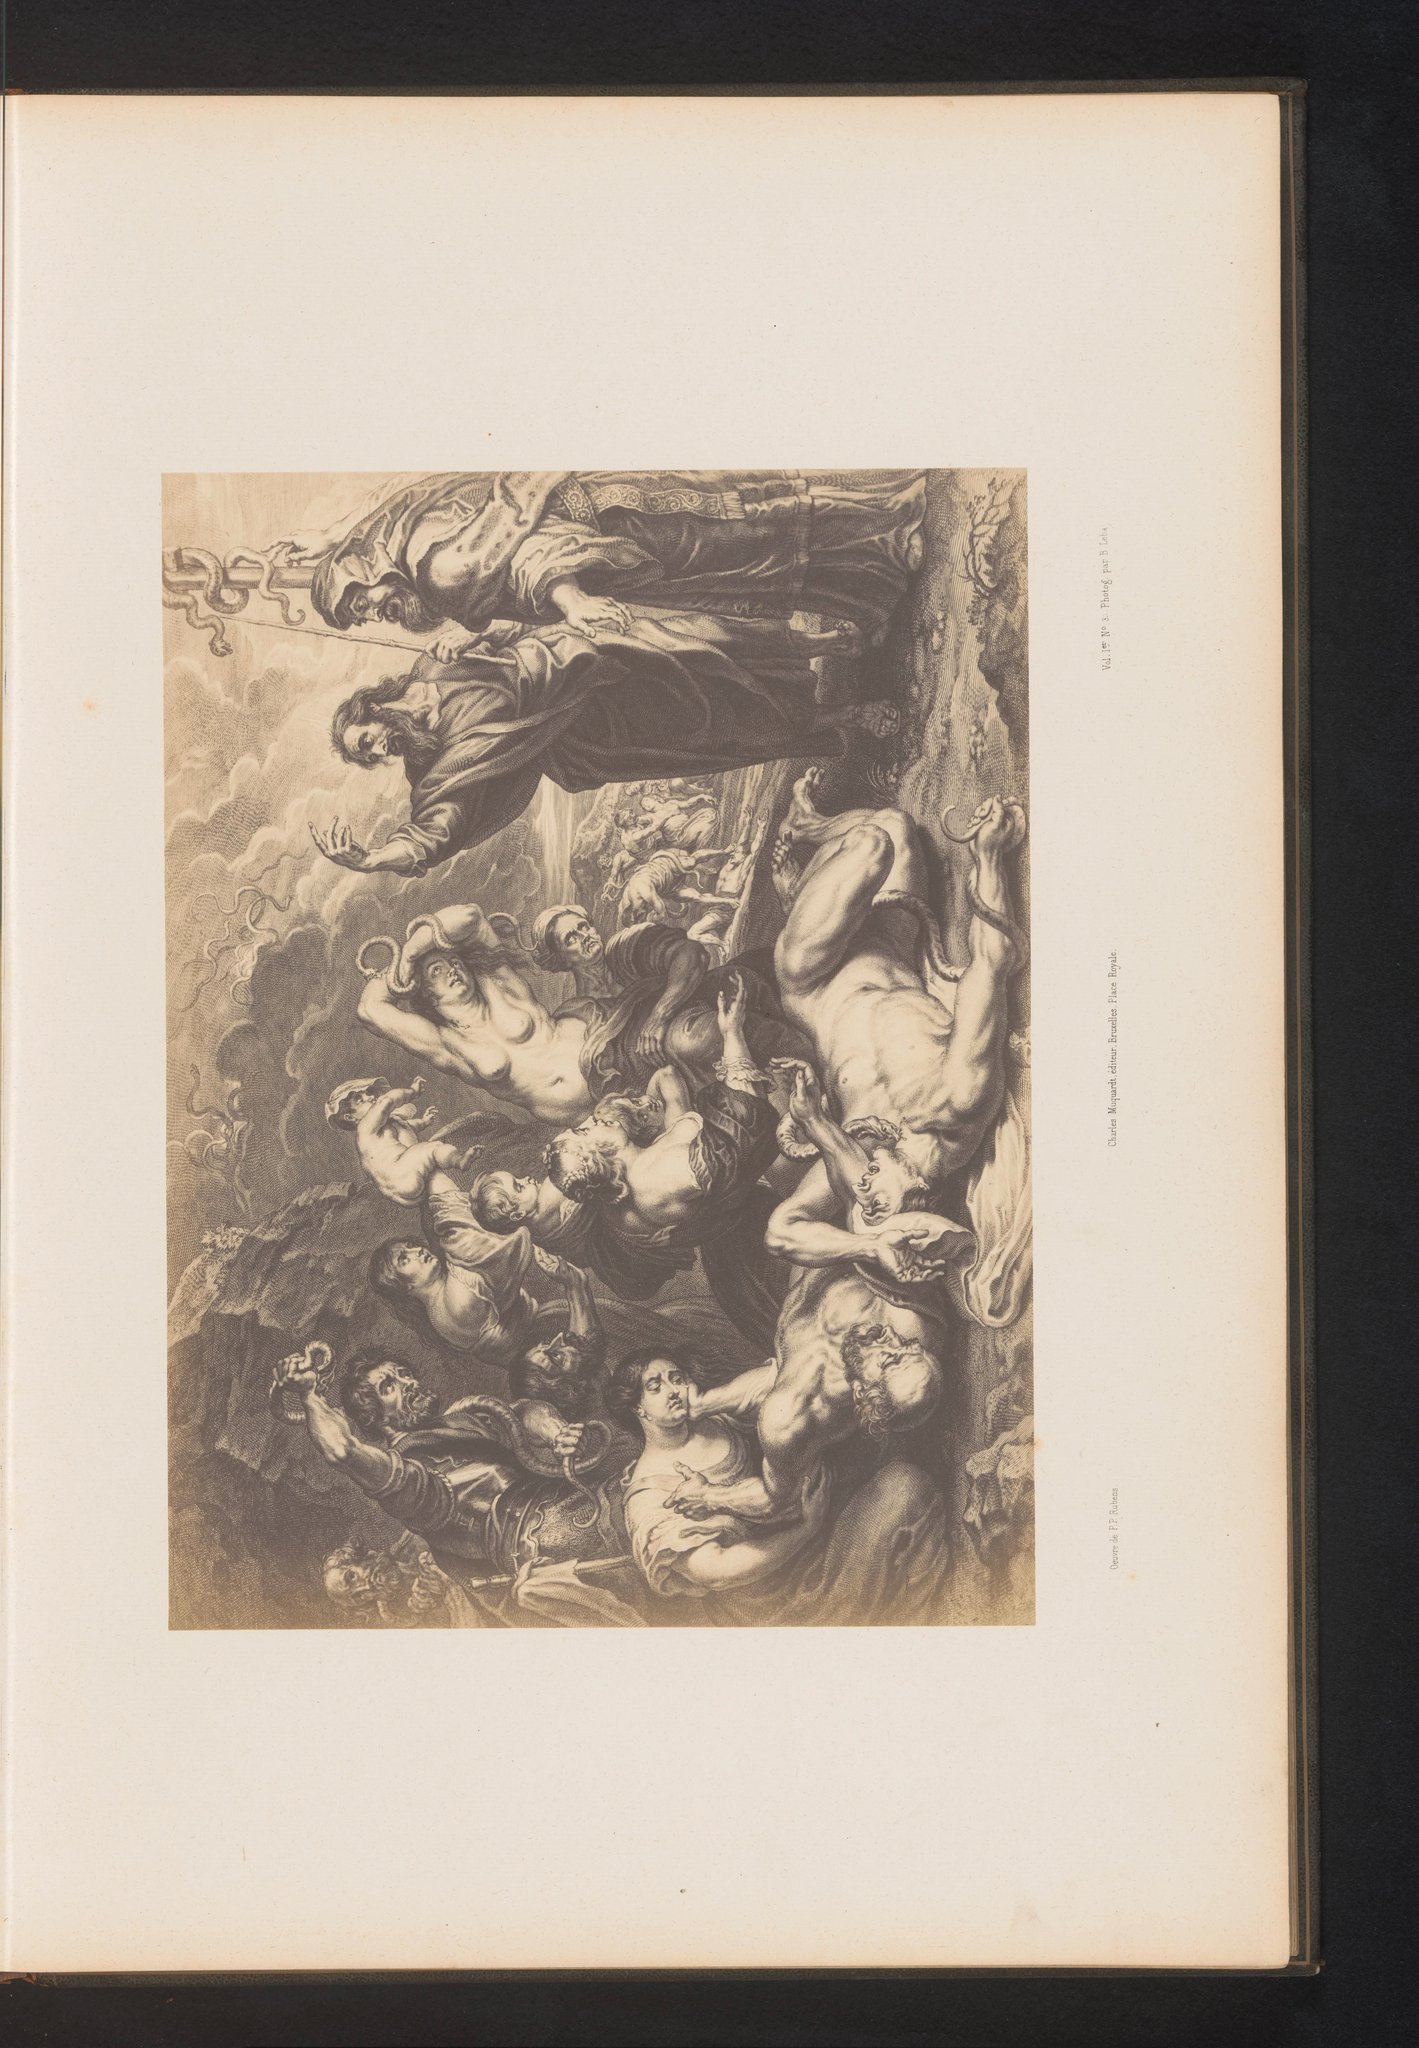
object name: reproduction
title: Fotoreproductie van een gravure van Mozes en de bronzen slang door Schelte Adamsz. Bolswert, naar het schilderij door Peter Paul Rubens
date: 1853-1858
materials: photographic support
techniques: albumen print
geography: brussels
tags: the brazen serpent (numbers 21:4-9)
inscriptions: number: ‘Vol. 1er. No 3.’